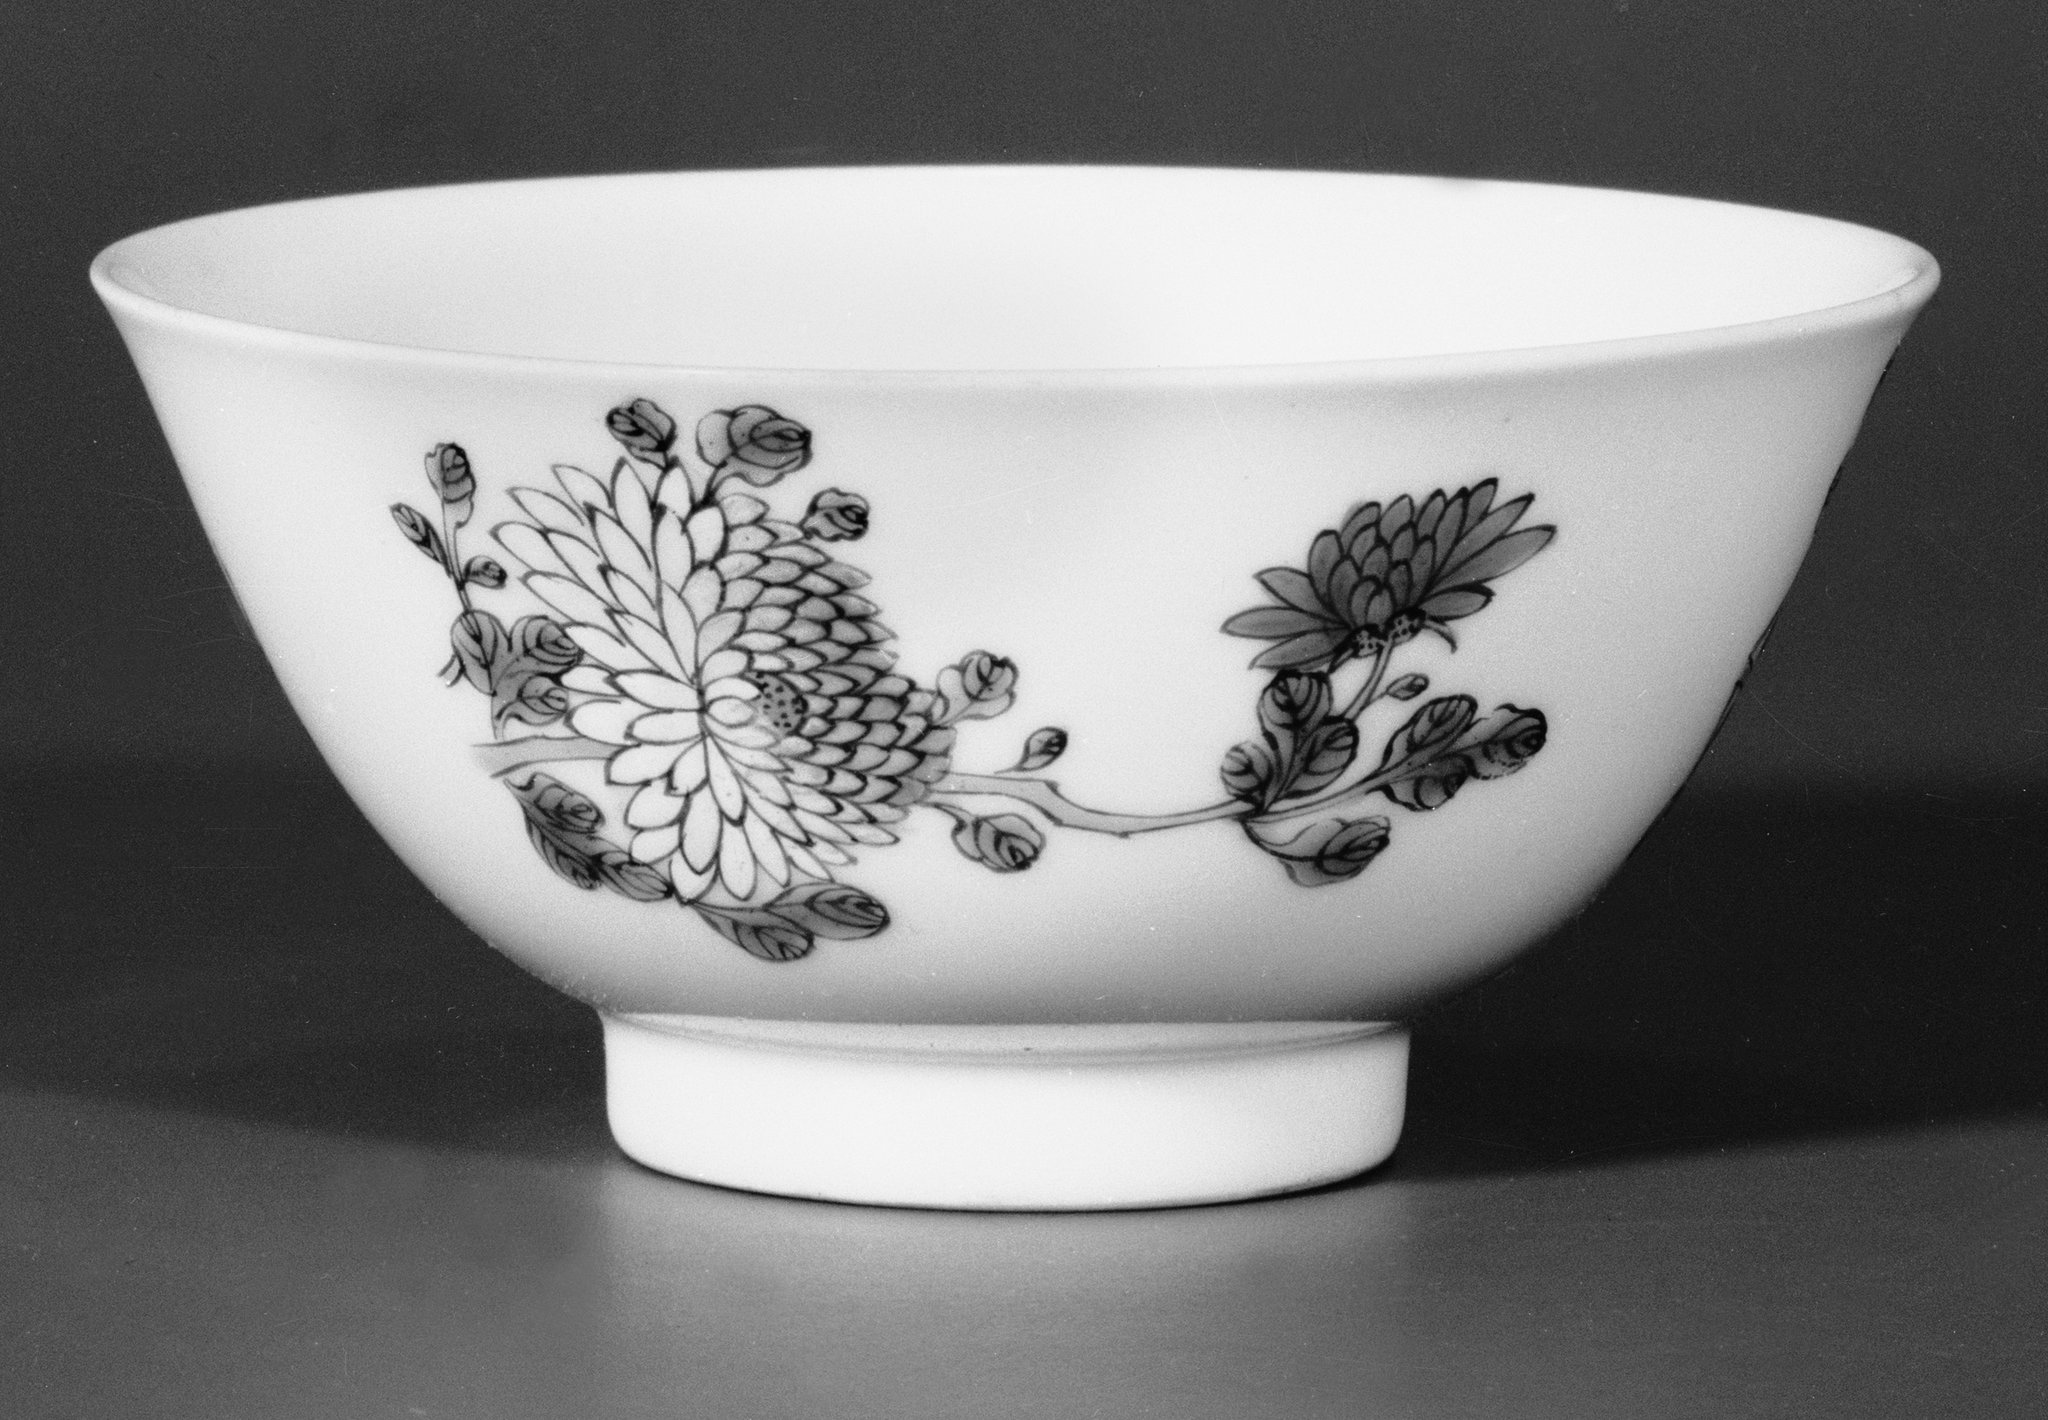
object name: bowl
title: Bowl with flowers (one of a pair)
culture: chinese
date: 1734-1766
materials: enamel, porcelain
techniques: overglaze, painting, polychrome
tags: flowers